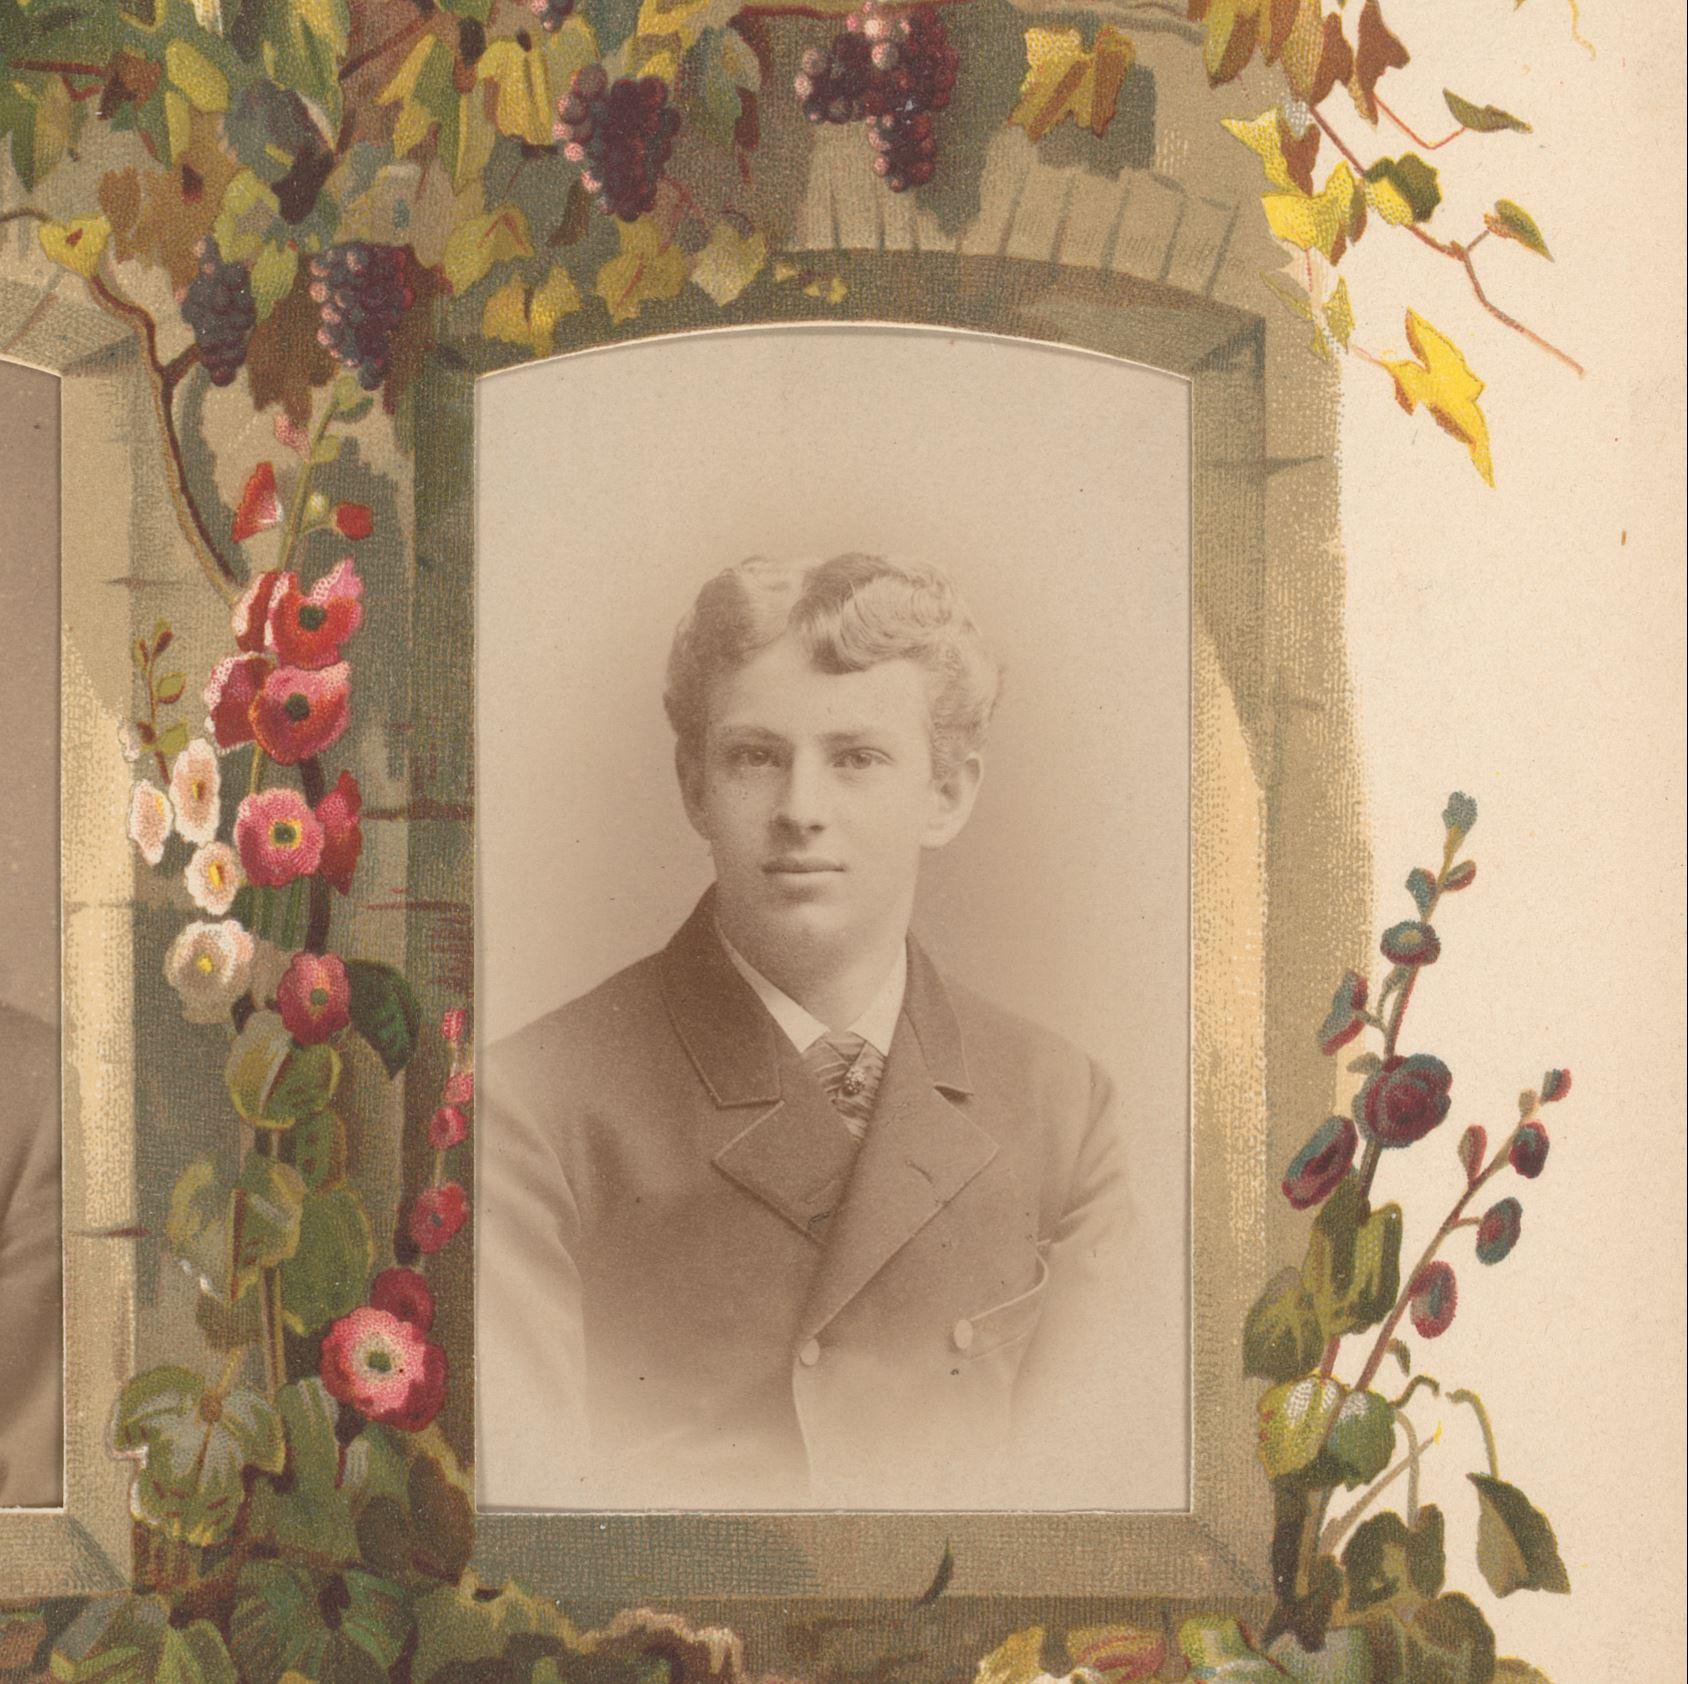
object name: carte de visite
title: Portret van een jonge man, aangeduid als Gustav Schader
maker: carl bräunlich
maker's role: fotograaf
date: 1850-1900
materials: cardboard, photographic support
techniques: albumen print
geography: jena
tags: historical persons, youth, adolescent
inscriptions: inscription: ‘CARL BRÄUNLICH/ (...)/ HERZOGL. SACHS ALTERNBURG HOF PHOTOGRAPH/ JENA/ AM HOLZMARKT./ Die Platten werden für Nachbestellungen reservirt.’, annotation: ‘Gustav Schrader †’